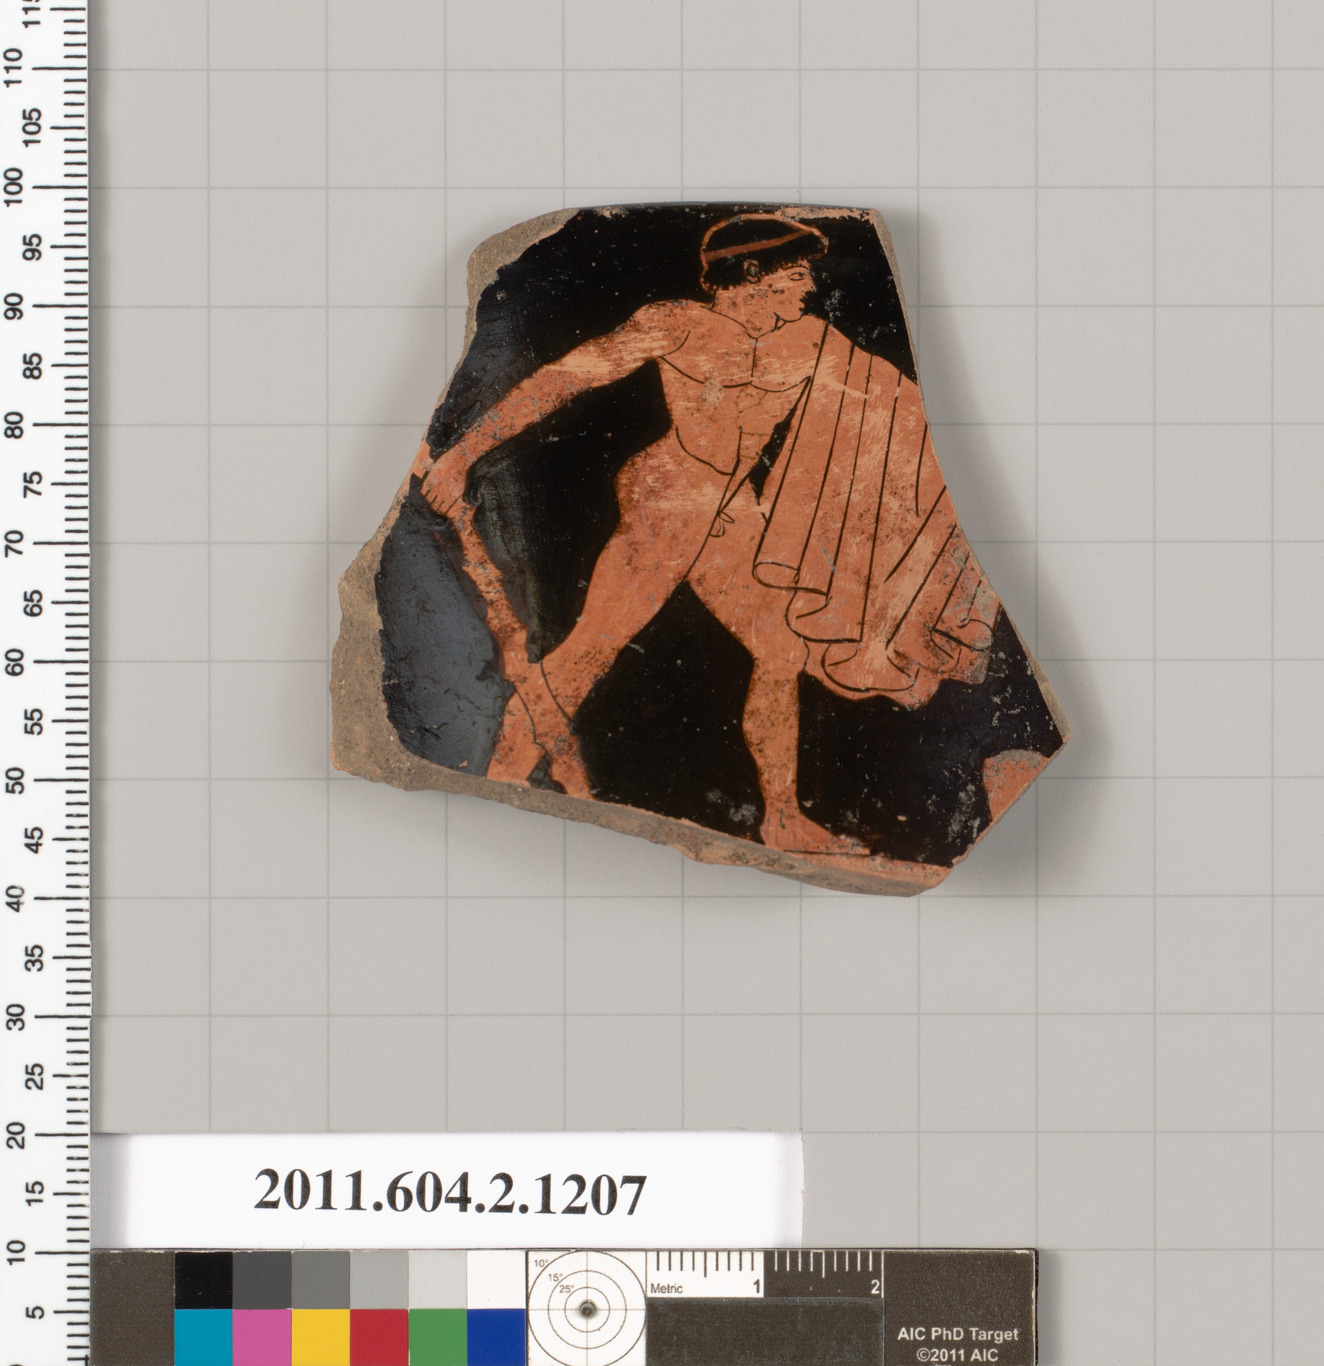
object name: kantharos fragment, head vase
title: Terracotta fragment from a kantharos: head vase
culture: greek, attic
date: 490-470 BCE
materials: terracotta